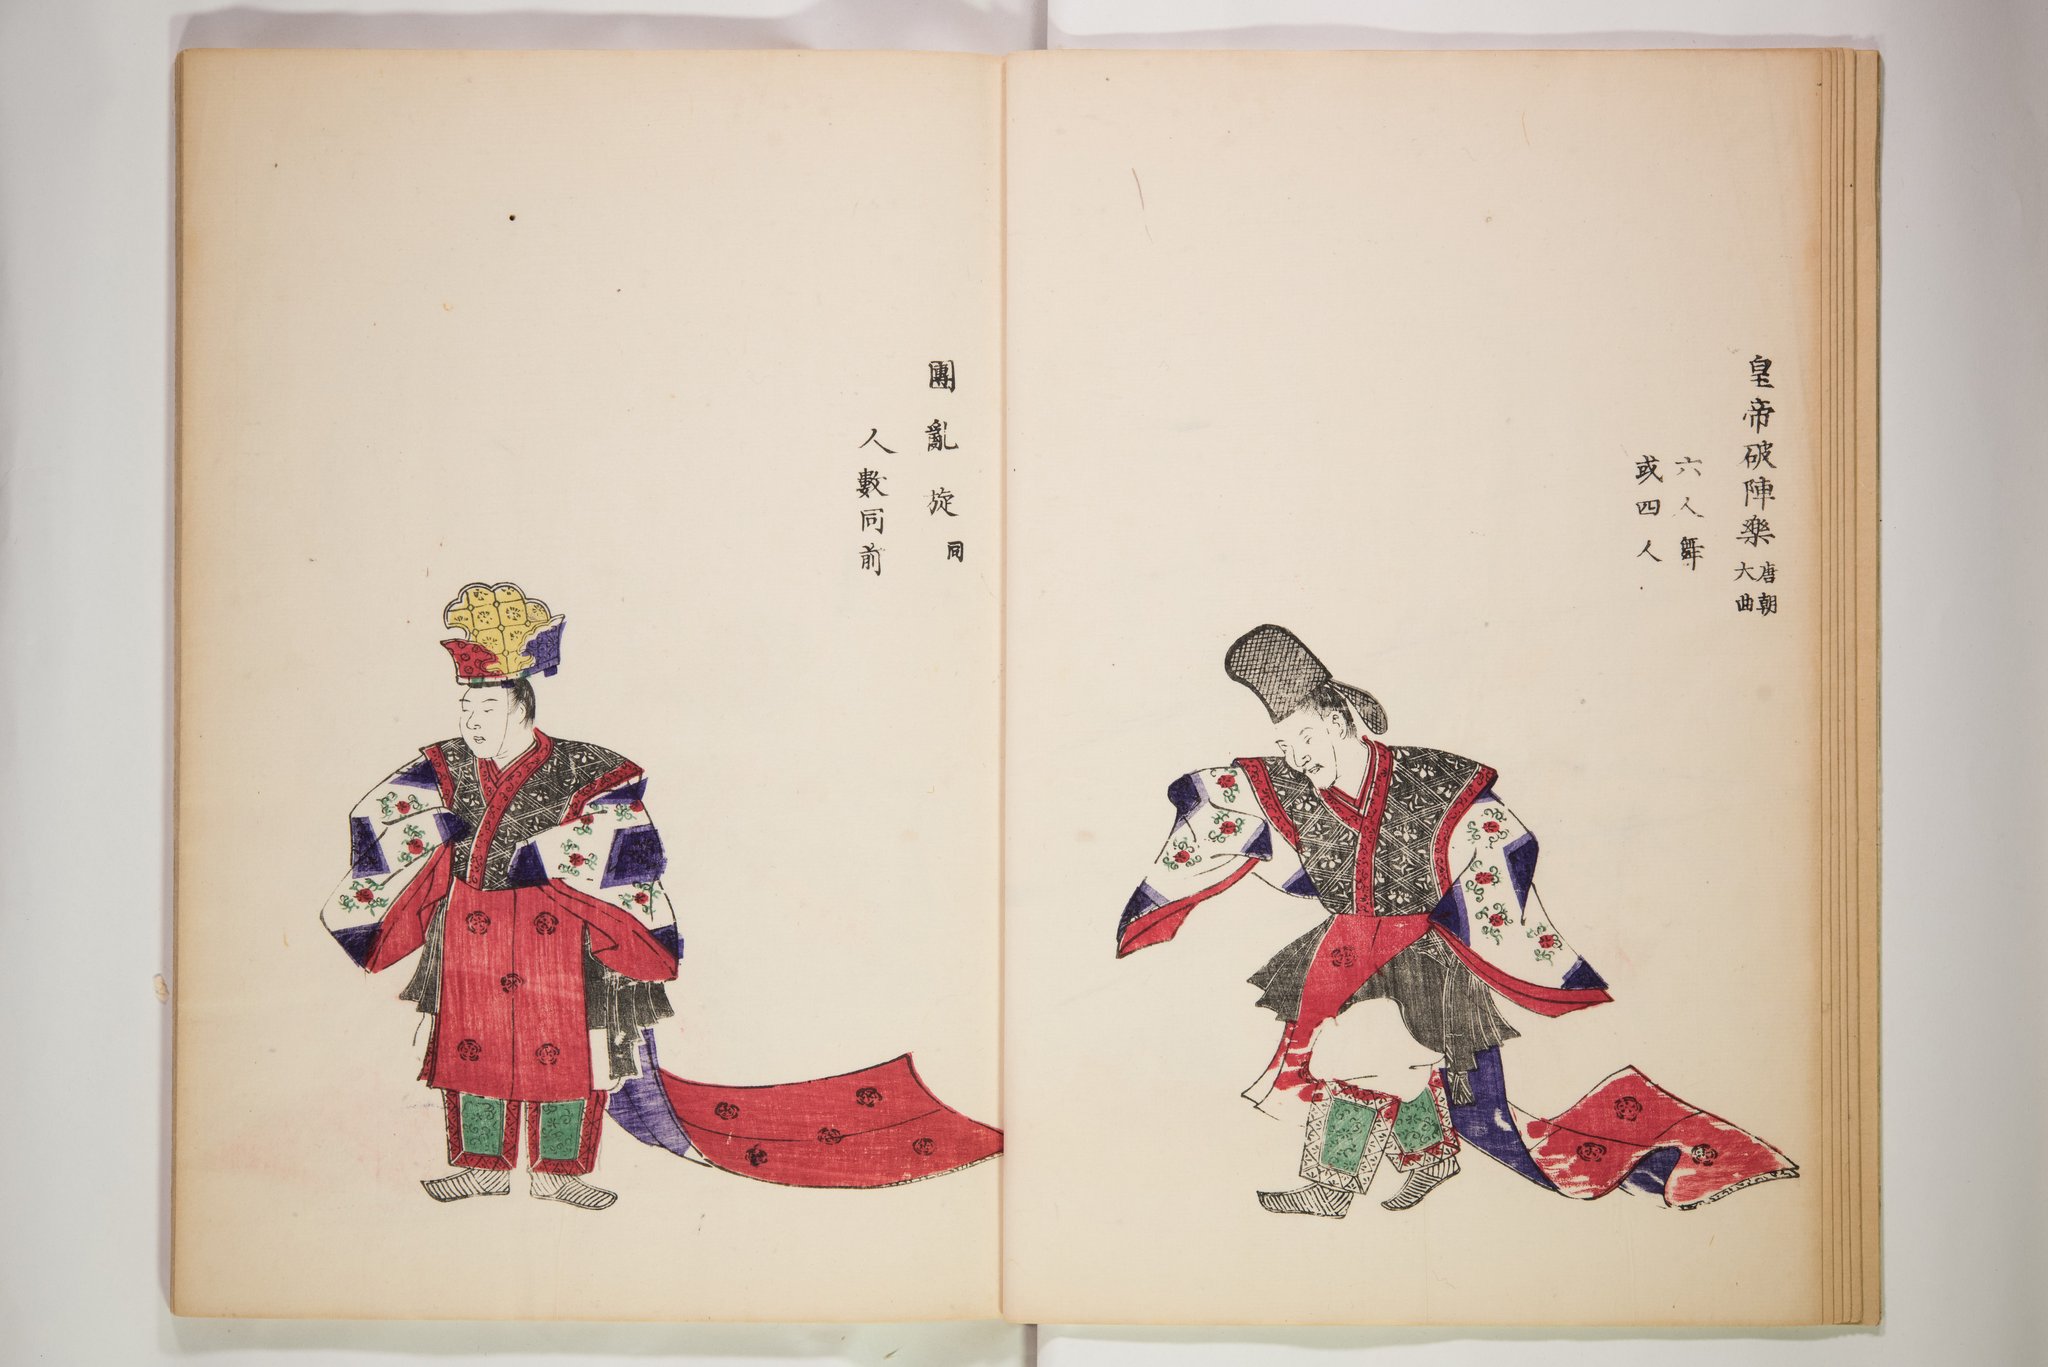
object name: illustrated book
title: Illustrations on Bugaku (Bugakuzu) 舞楽図 （ぶがくず）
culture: japanese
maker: takashima chiharu 高島千春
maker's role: artist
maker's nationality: japanese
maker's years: 1777-1859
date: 1823-1828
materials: ink, paper